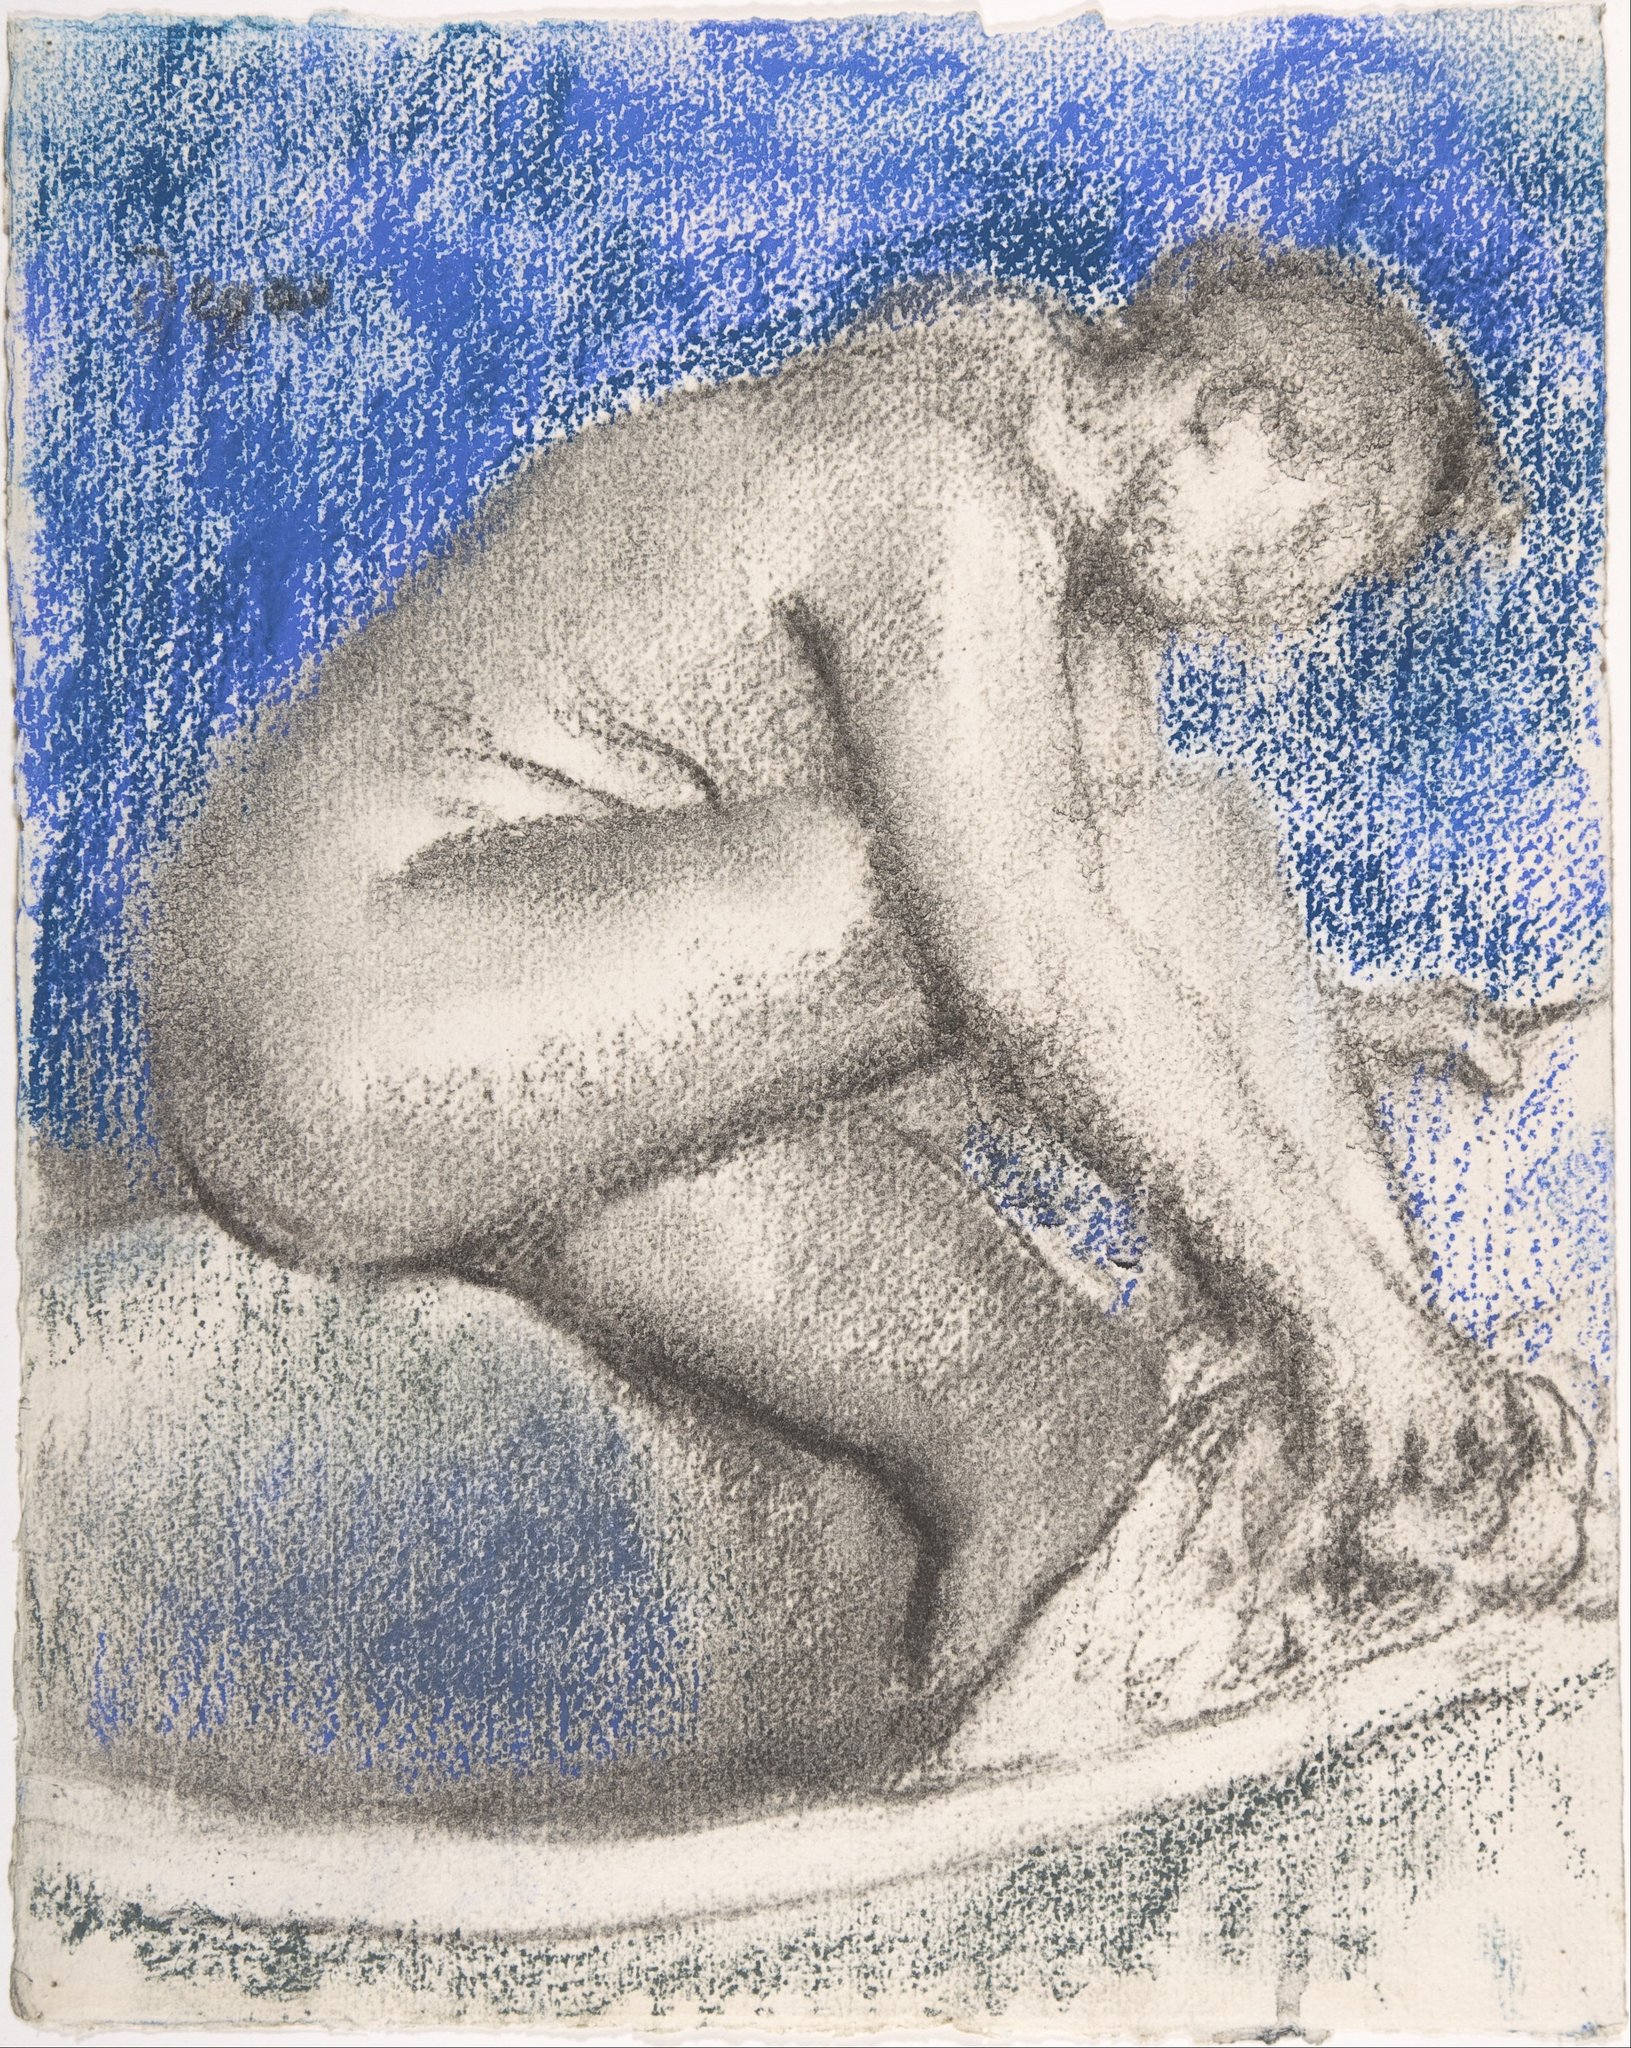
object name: drawing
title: The Bath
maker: edgar degas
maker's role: artist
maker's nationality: french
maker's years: 1834-1917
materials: charcoal, pastel, paper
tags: female nudes,bathing